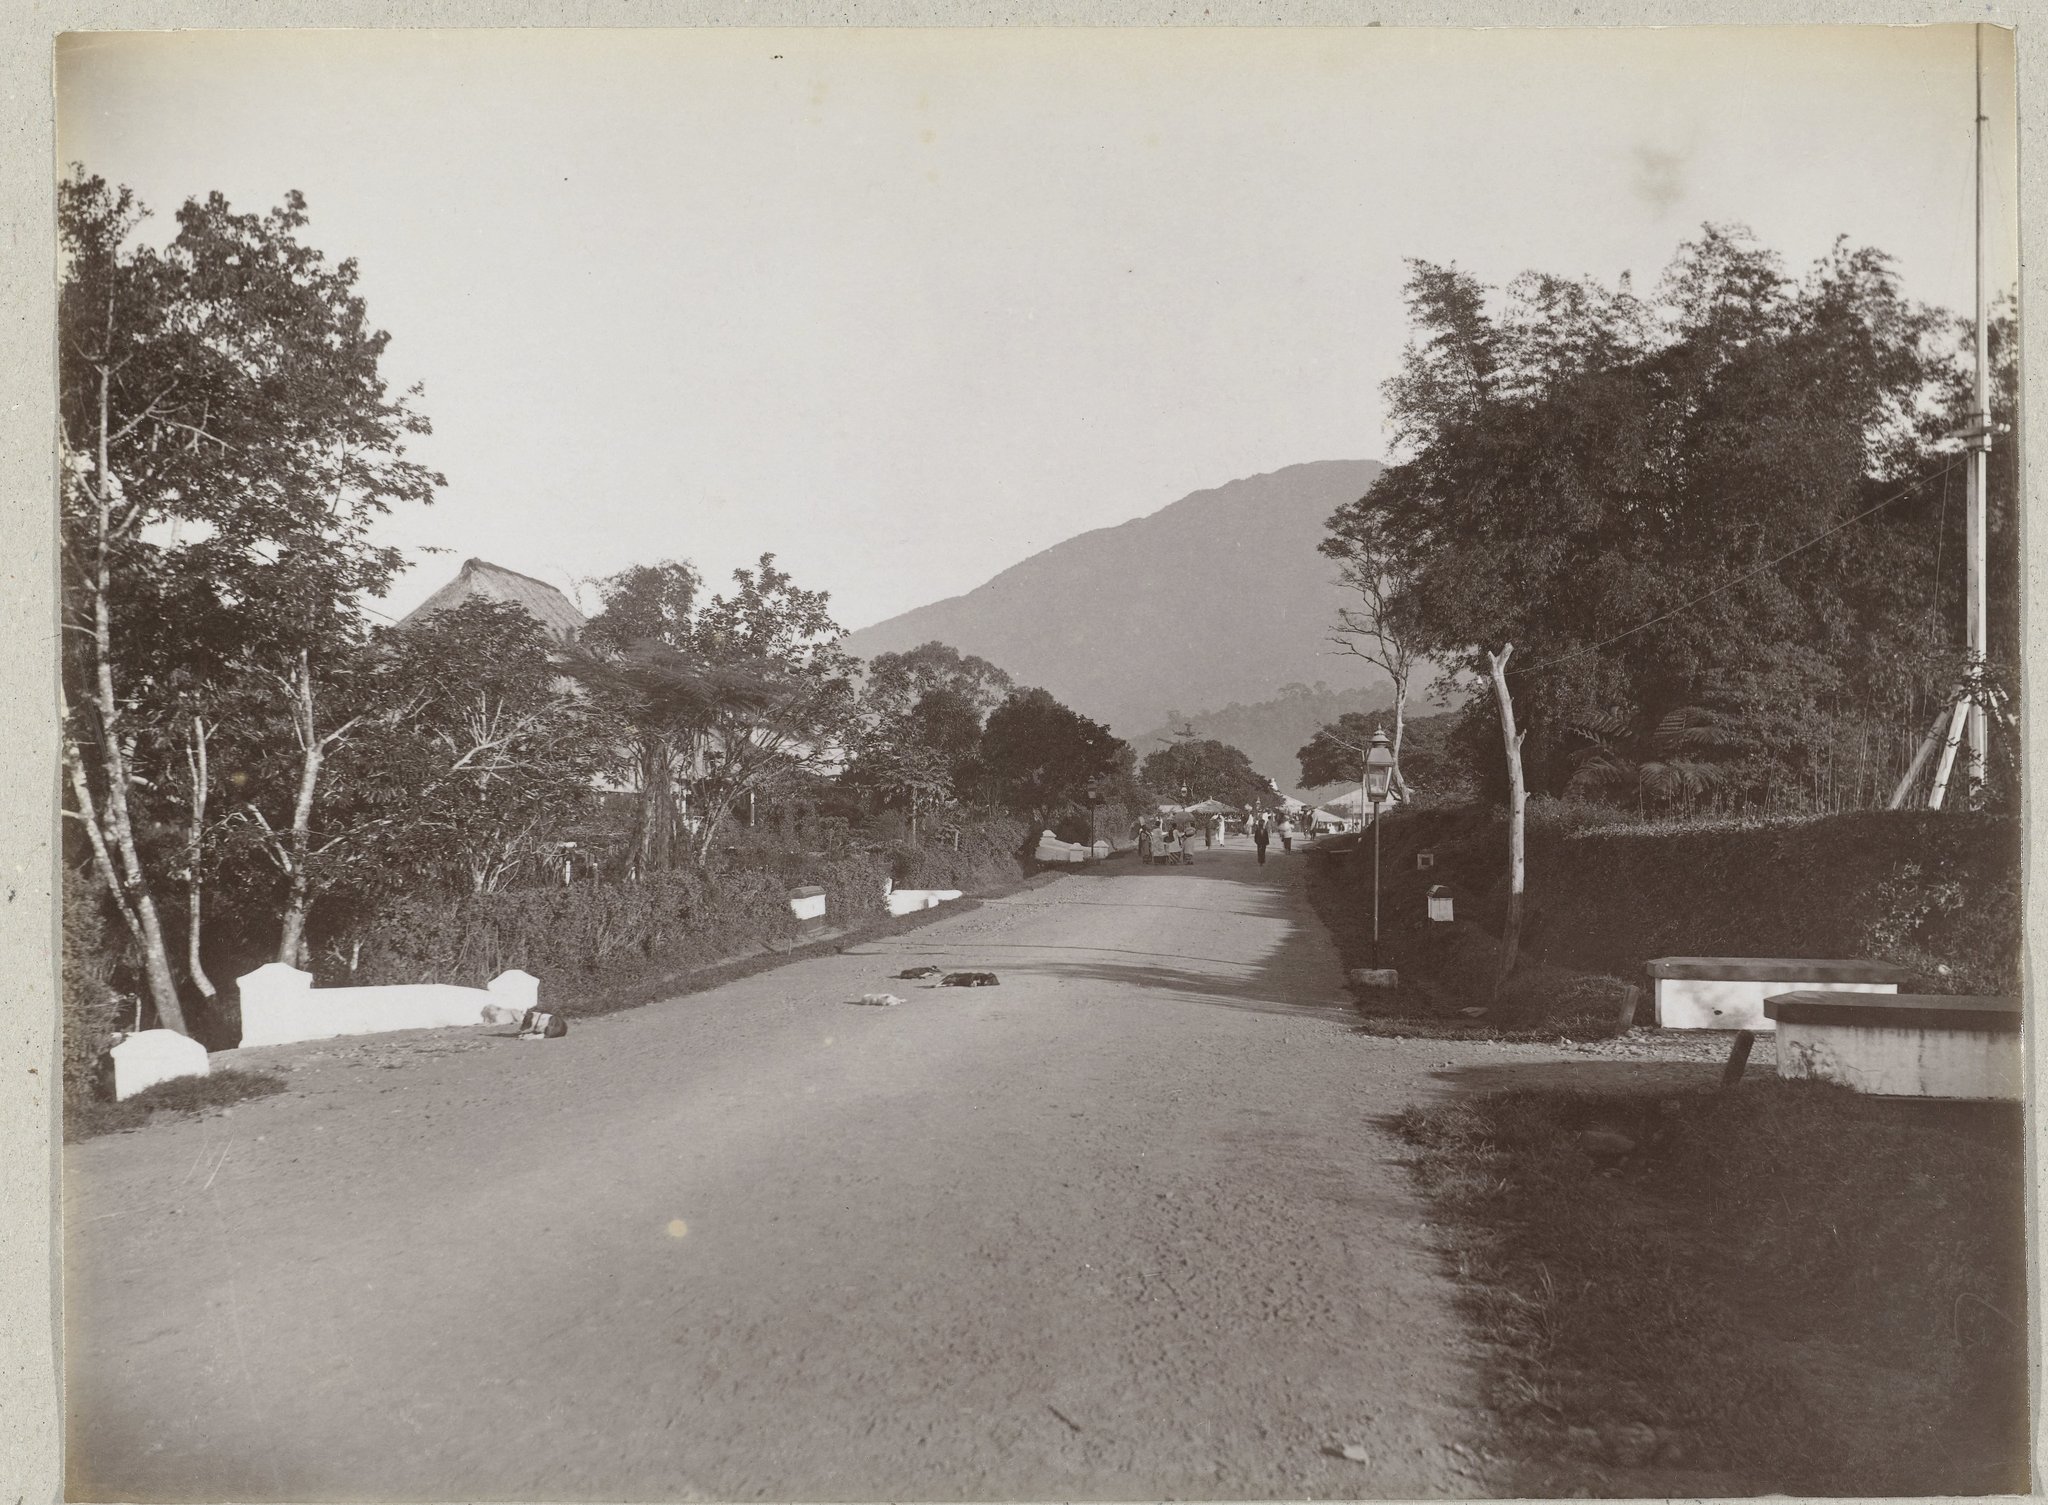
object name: photograph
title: Straatgezicht in Padang Pandjang met uitzicht op de vulkaan Marapi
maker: christiaan benjamin nieuwenhuis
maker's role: publisher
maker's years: 1863-1922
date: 1891-1912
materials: paper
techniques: albumen print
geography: padang pandjang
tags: volcano, street, dog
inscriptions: inscription: ‘Pad Pandjang’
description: Straatgezicht in Pandjang met op straat een aantal slapende honden. Tegne de achtergrond is de gunung Marapi zichtbaar